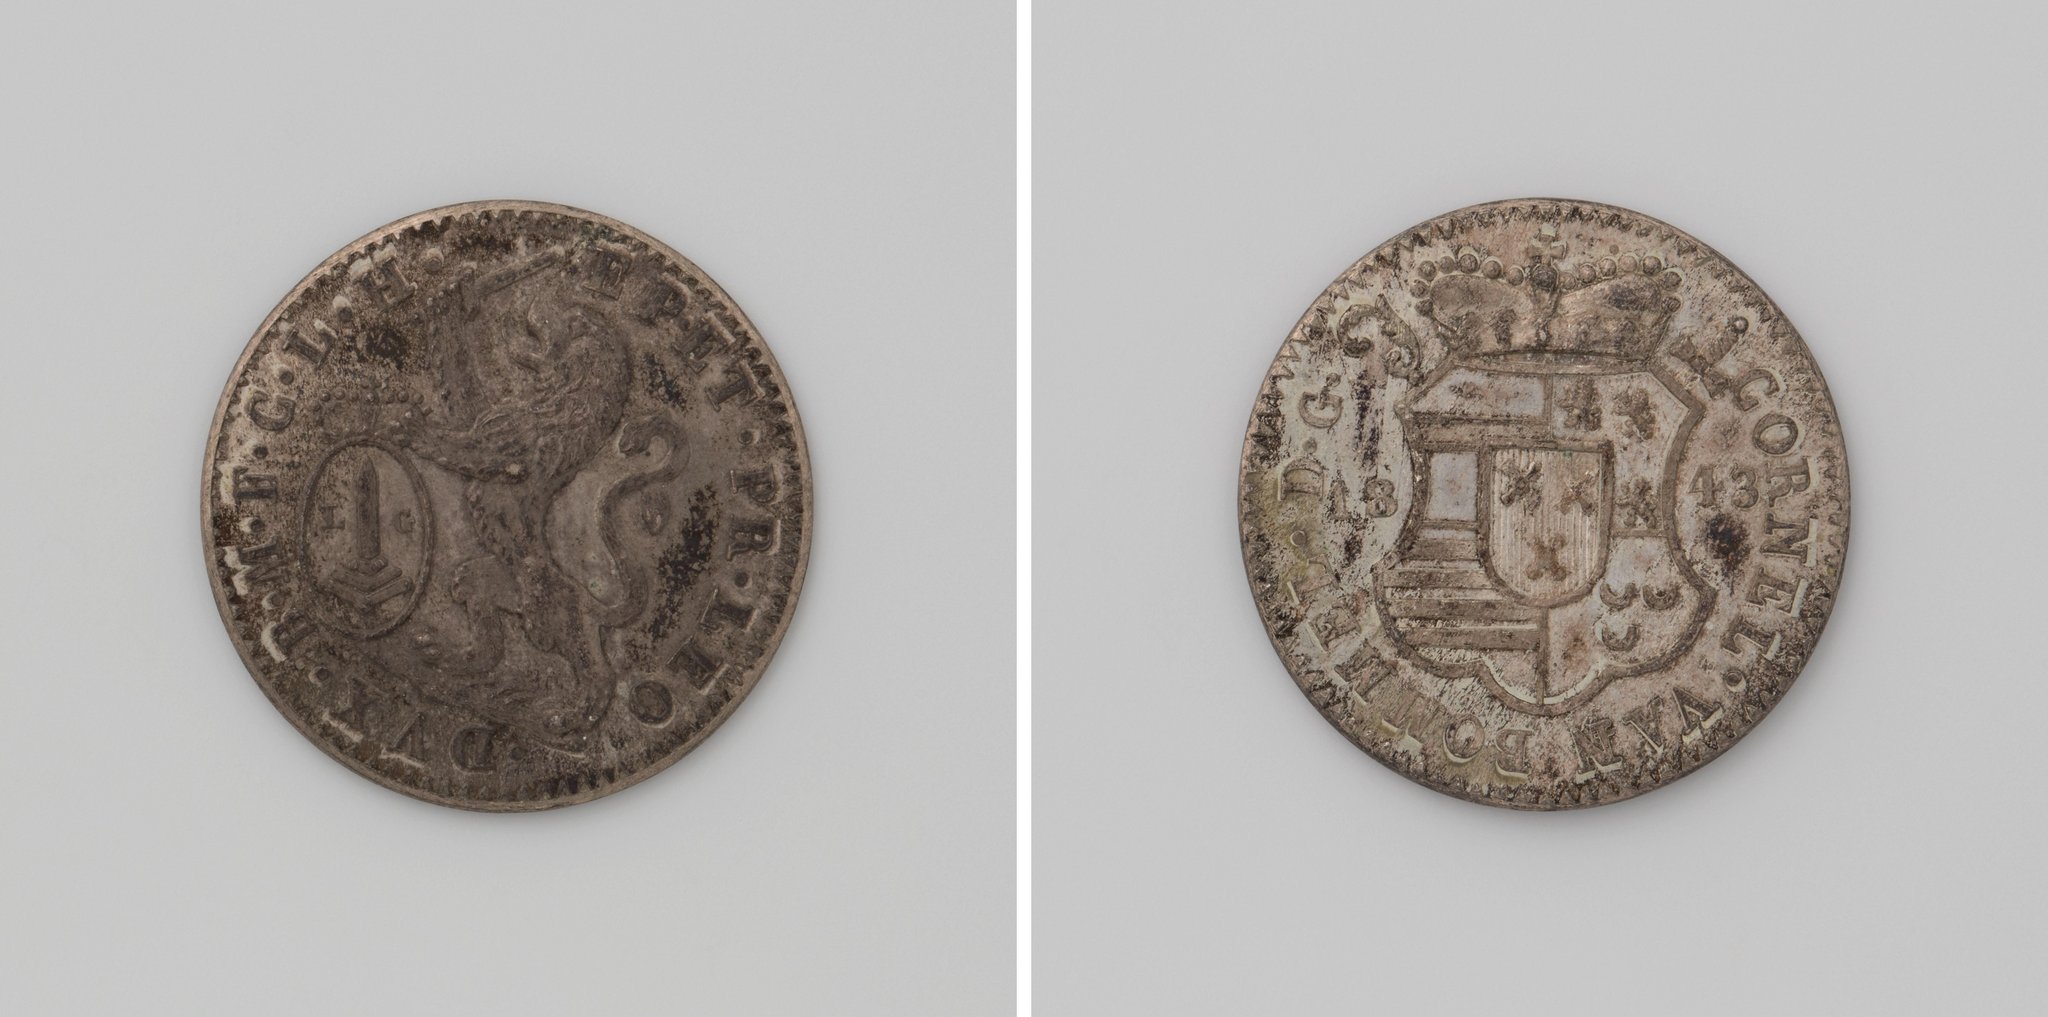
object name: history medal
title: Cornelius van Bommel, bisschop van Luik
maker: Anonymous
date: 1843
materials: silver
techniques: striking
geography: belgium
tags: liège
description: Zilveren penning. Voorzijde: leeuw met getrokken zwaard en gekroond wapenschild binnen omschrift. Keerzijde: gekroond wapenschild binnen omschrift